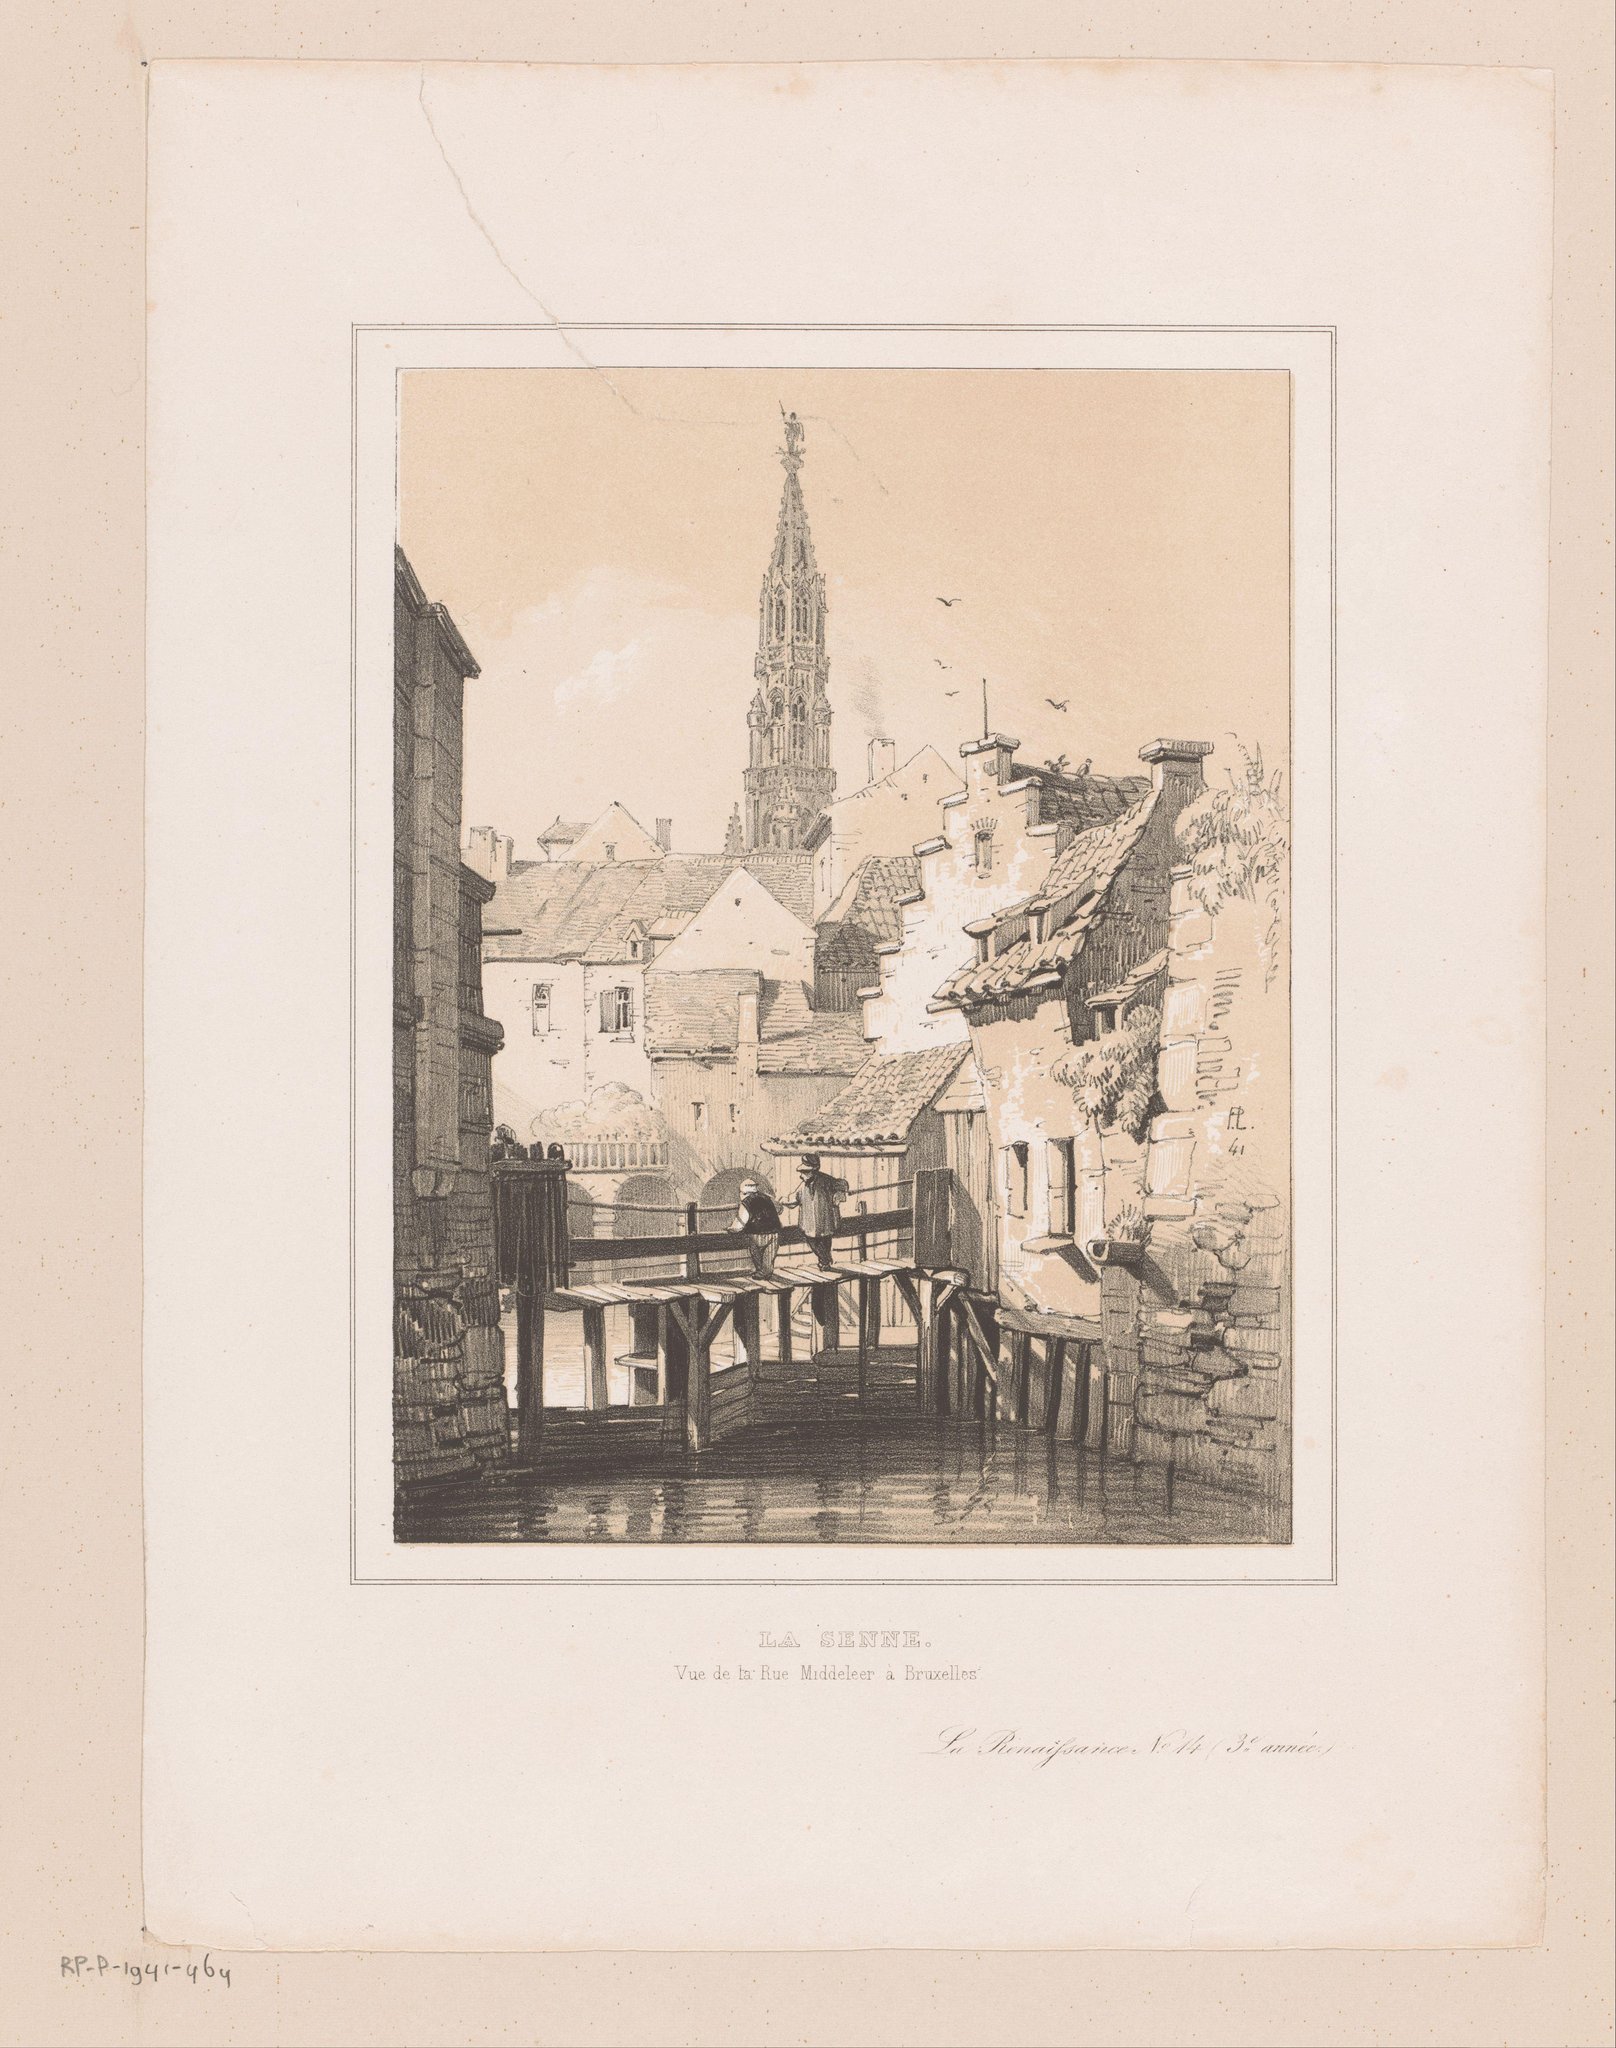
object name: print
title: Stadsgezicht in Brussel met toren van het stadhuis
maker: paulus lauters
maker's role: print maker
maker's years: 1806-1875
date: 1841-1842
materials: paper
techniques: tone lithography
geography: brussels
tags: city-view in general; 'veduta', townhall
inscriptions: collector's mark: Lugt 2228, collector's mark: Lugt 2760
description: Twee figuren op een brug over de Zenne, met op de achtergrond de toren van het stadhuis. Rechtsonder genummerd: La Renaissance, No. 14 (3e année).